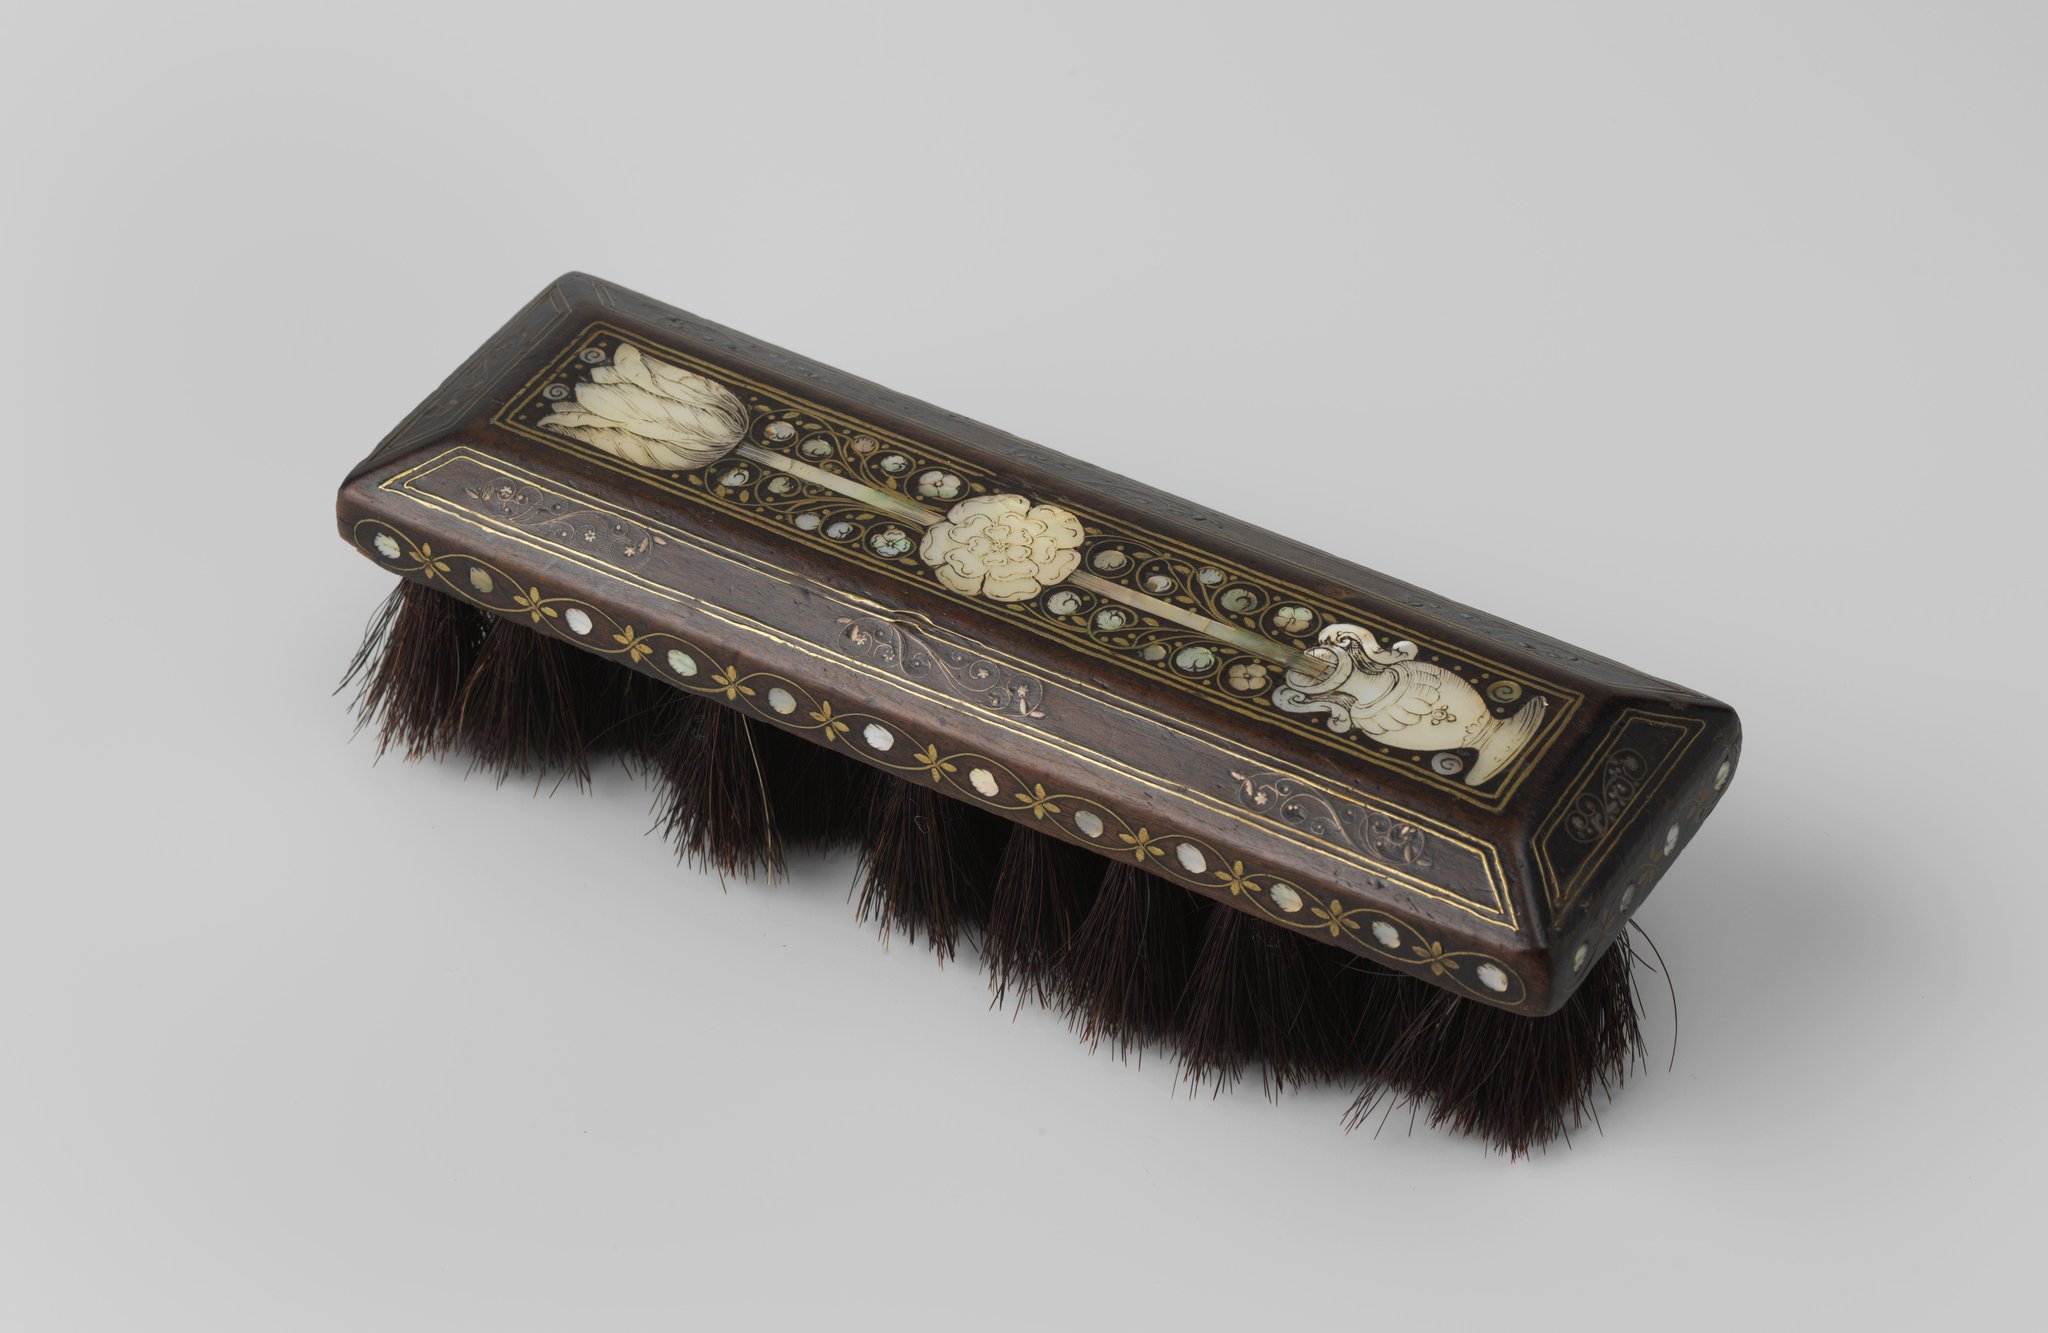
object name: brush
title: Borstel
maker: Anonymous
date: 1600-1699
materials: copper, mother of pearl, wood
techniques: engraving, intarsia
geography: netherlands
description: Borstel met een rug van palissanderhout, ingelegd met parelmoer en koper. Het verhoogde middenveld vertoont in gegraveerd parelmoer een vaas met een tulp op een rechte stengel en een rozet in het midden. De tulp wordt geflankeerd door ingelegde koperen ranken met bloemkelken in parelmoer. Om het middenveld zijn banen met ranken en dubbele koperen randen aangebracht. De opstaande randen vertonen in koper een vlechtband met rozetten en bloemkelken in parelmoer. Onder de vaas gemerkt: CVR.